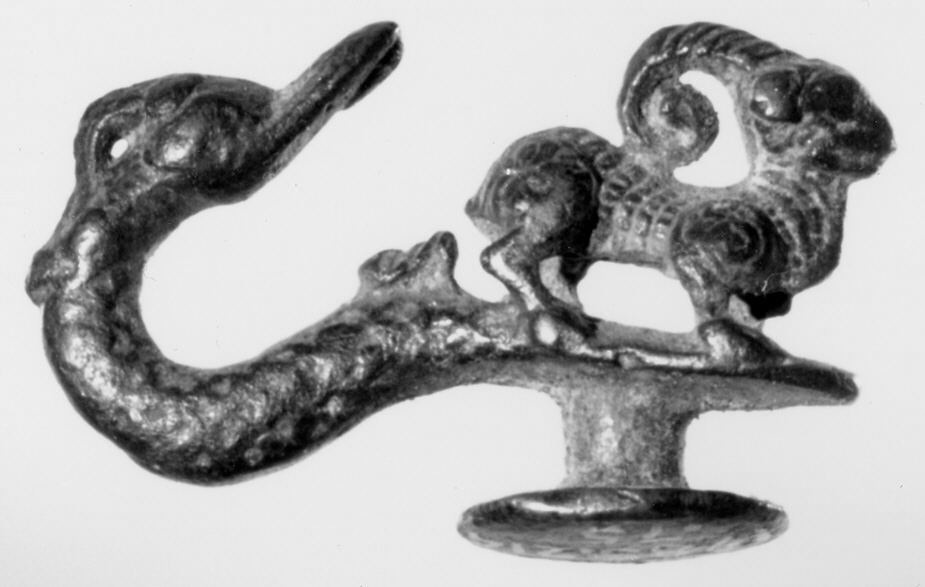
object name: belt hook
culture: chinese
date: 500-201 BCE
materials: bronze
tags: animals,birds